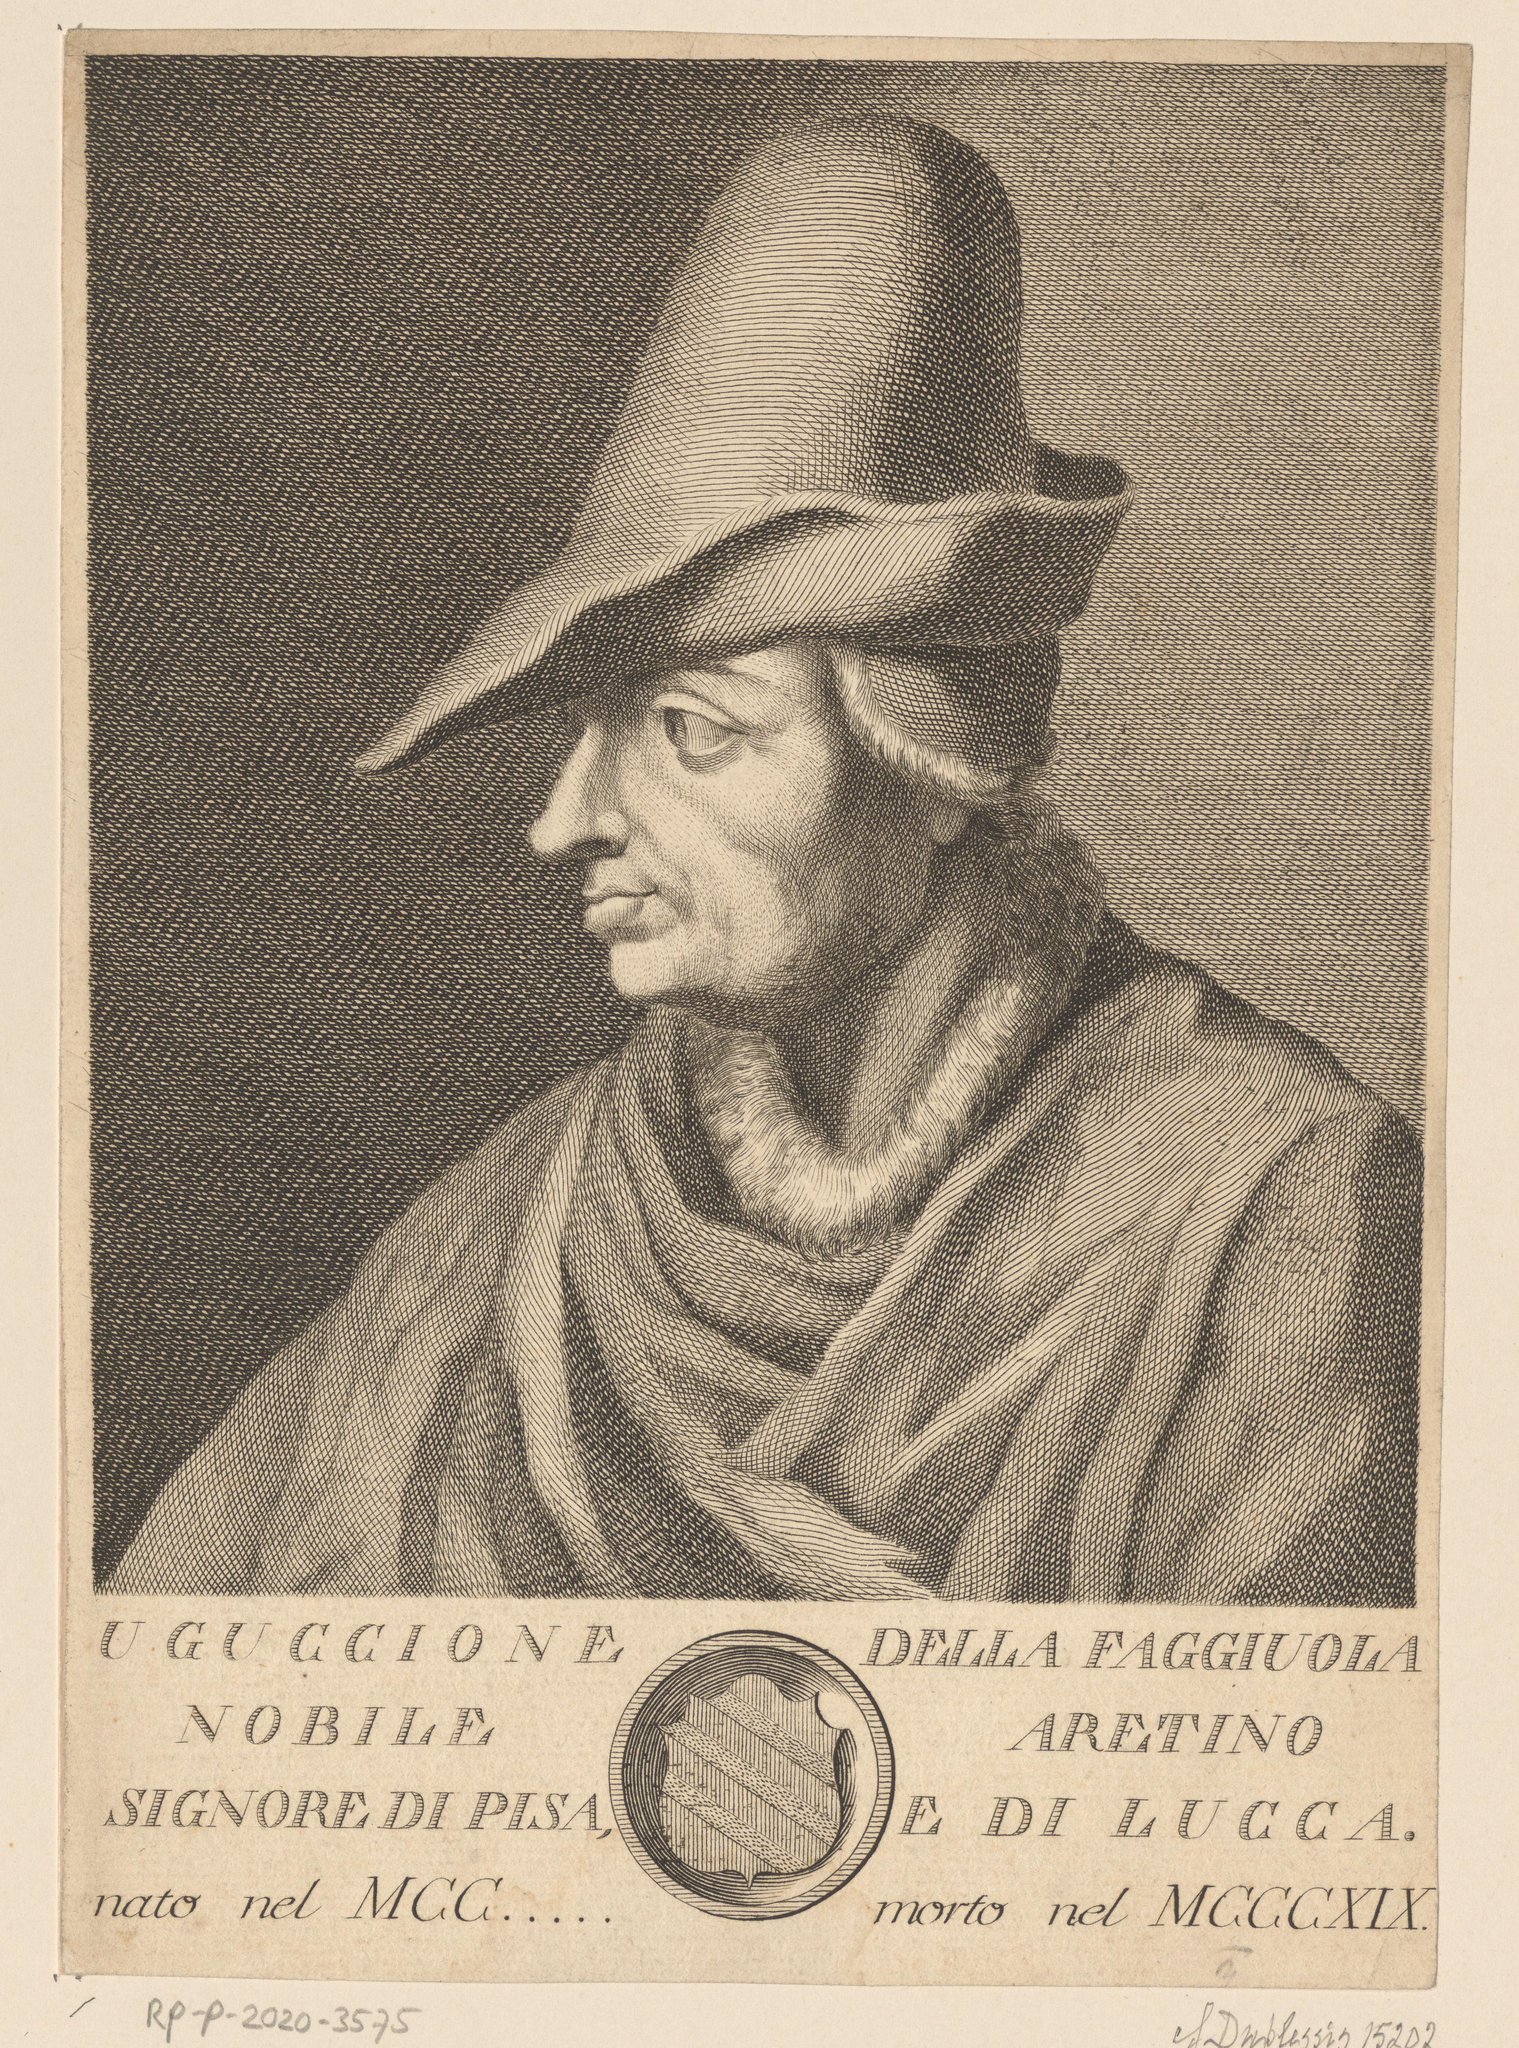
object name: print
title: Portret van Uguccione della Faggiola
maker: francesco allegrini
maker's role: print maker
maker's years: 1729-1773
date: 1762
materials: paper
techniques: engraving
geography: italy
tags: commander-in-chief, general, marshal, historical persons, armorial bearing, heraldry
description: Deze prent maakt deel uit van een reeks portretprenten van onbekende omvang. De prenten zijn gemaakt door verschillende prentmakers, onder wie Francesco Allegrini en Carlo en Raimondo Faucci.